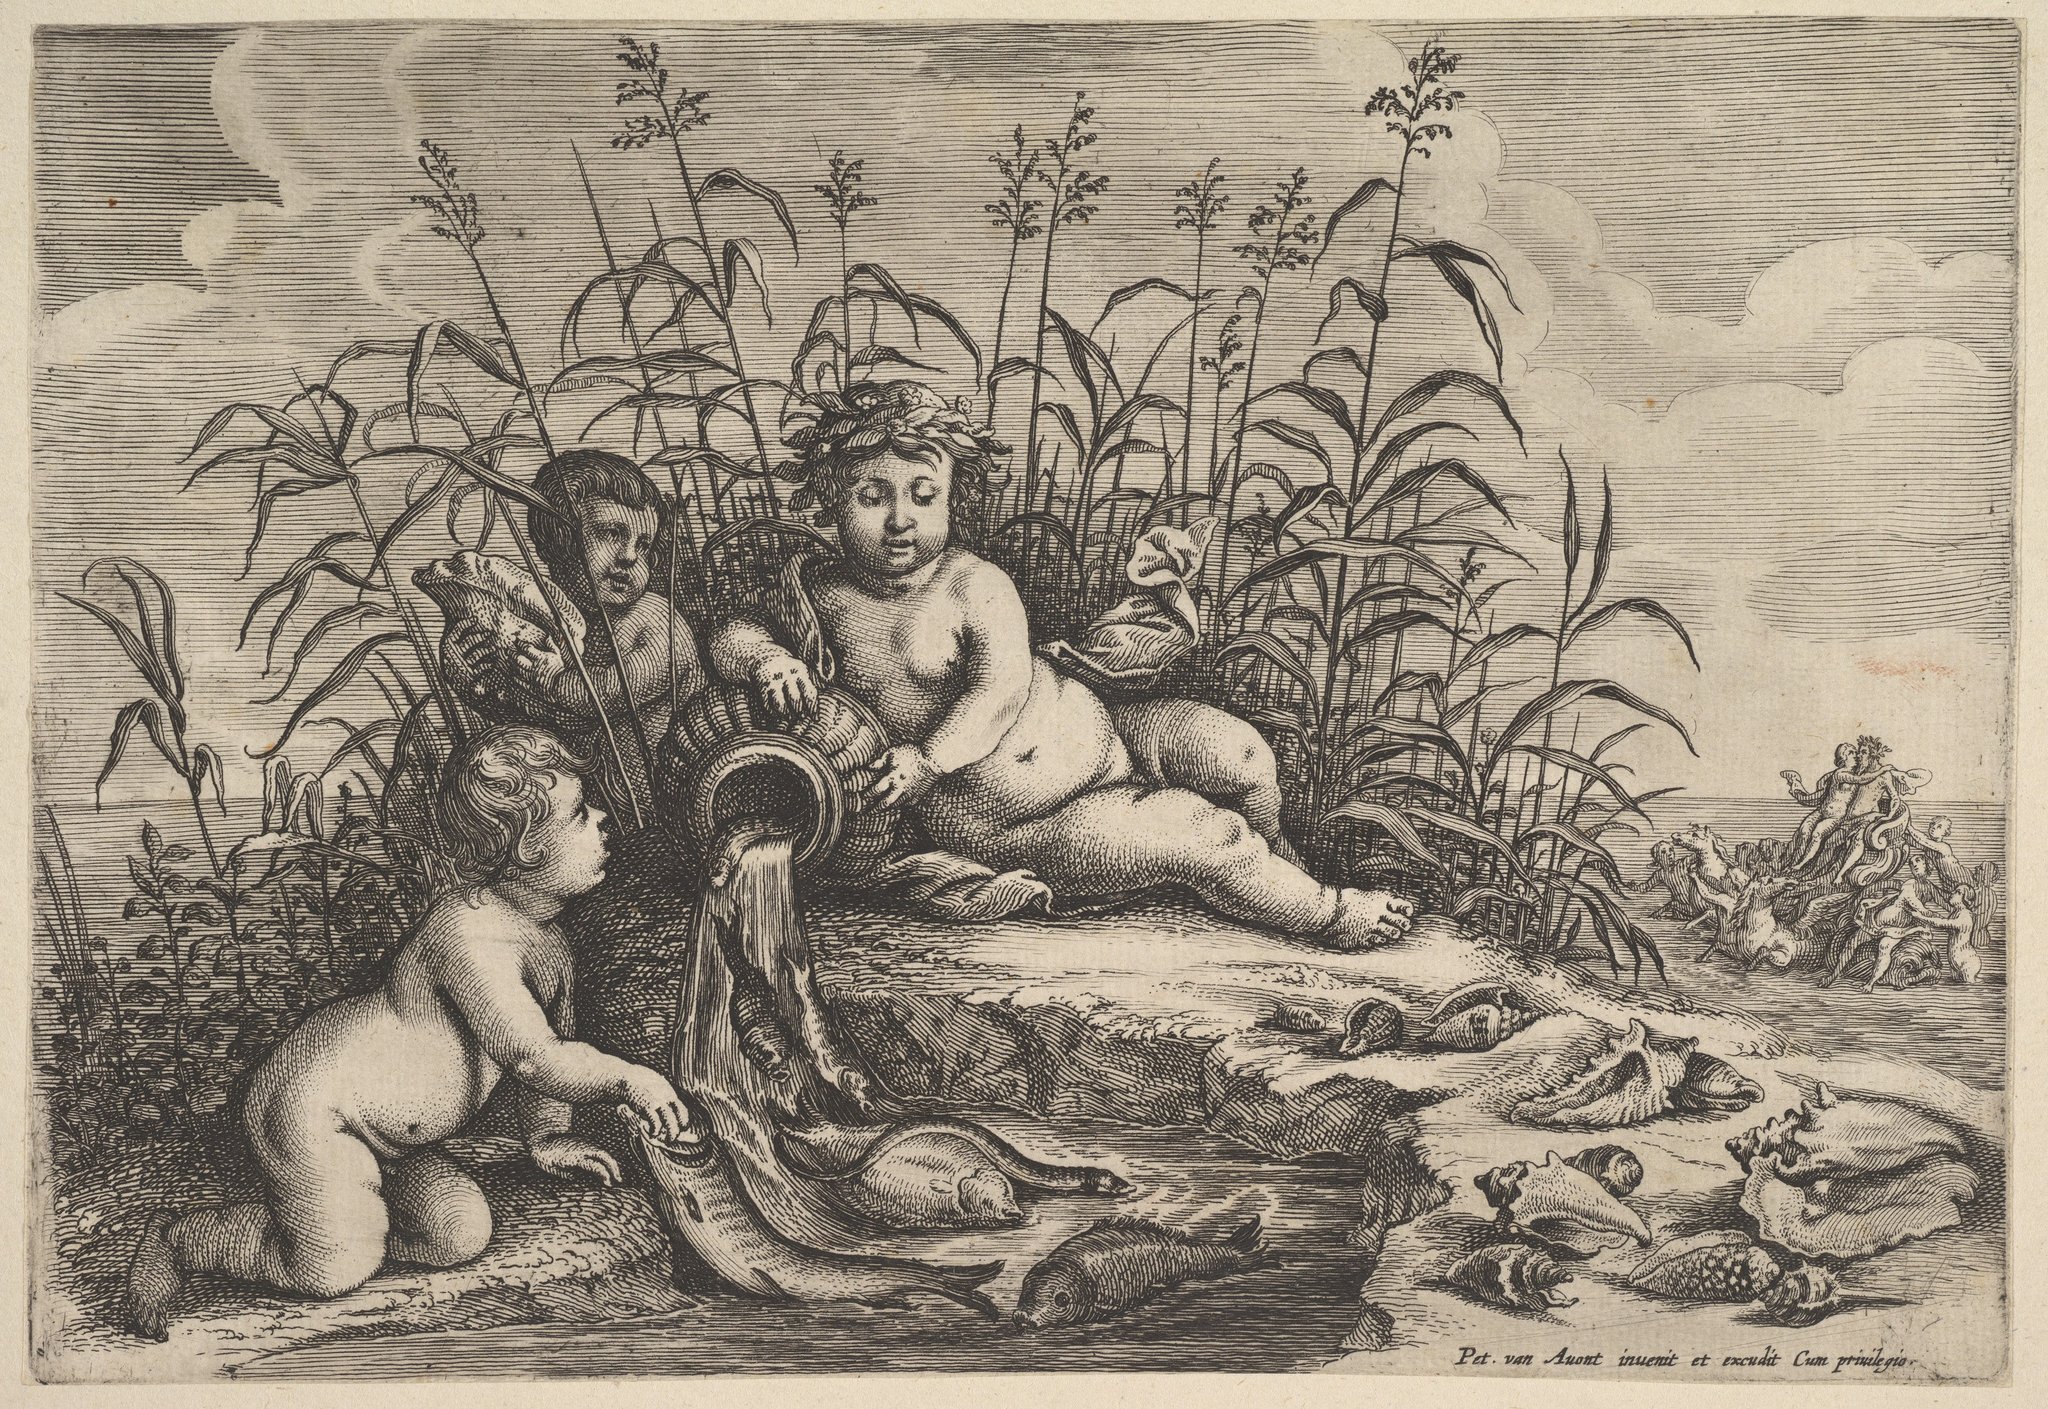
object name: print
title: Water, from "Four Elements"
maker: wenceslaus hollar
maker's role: artist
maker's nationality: bohemian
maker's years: 1607-1677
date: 1647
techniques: etching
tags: putti,fish,shells